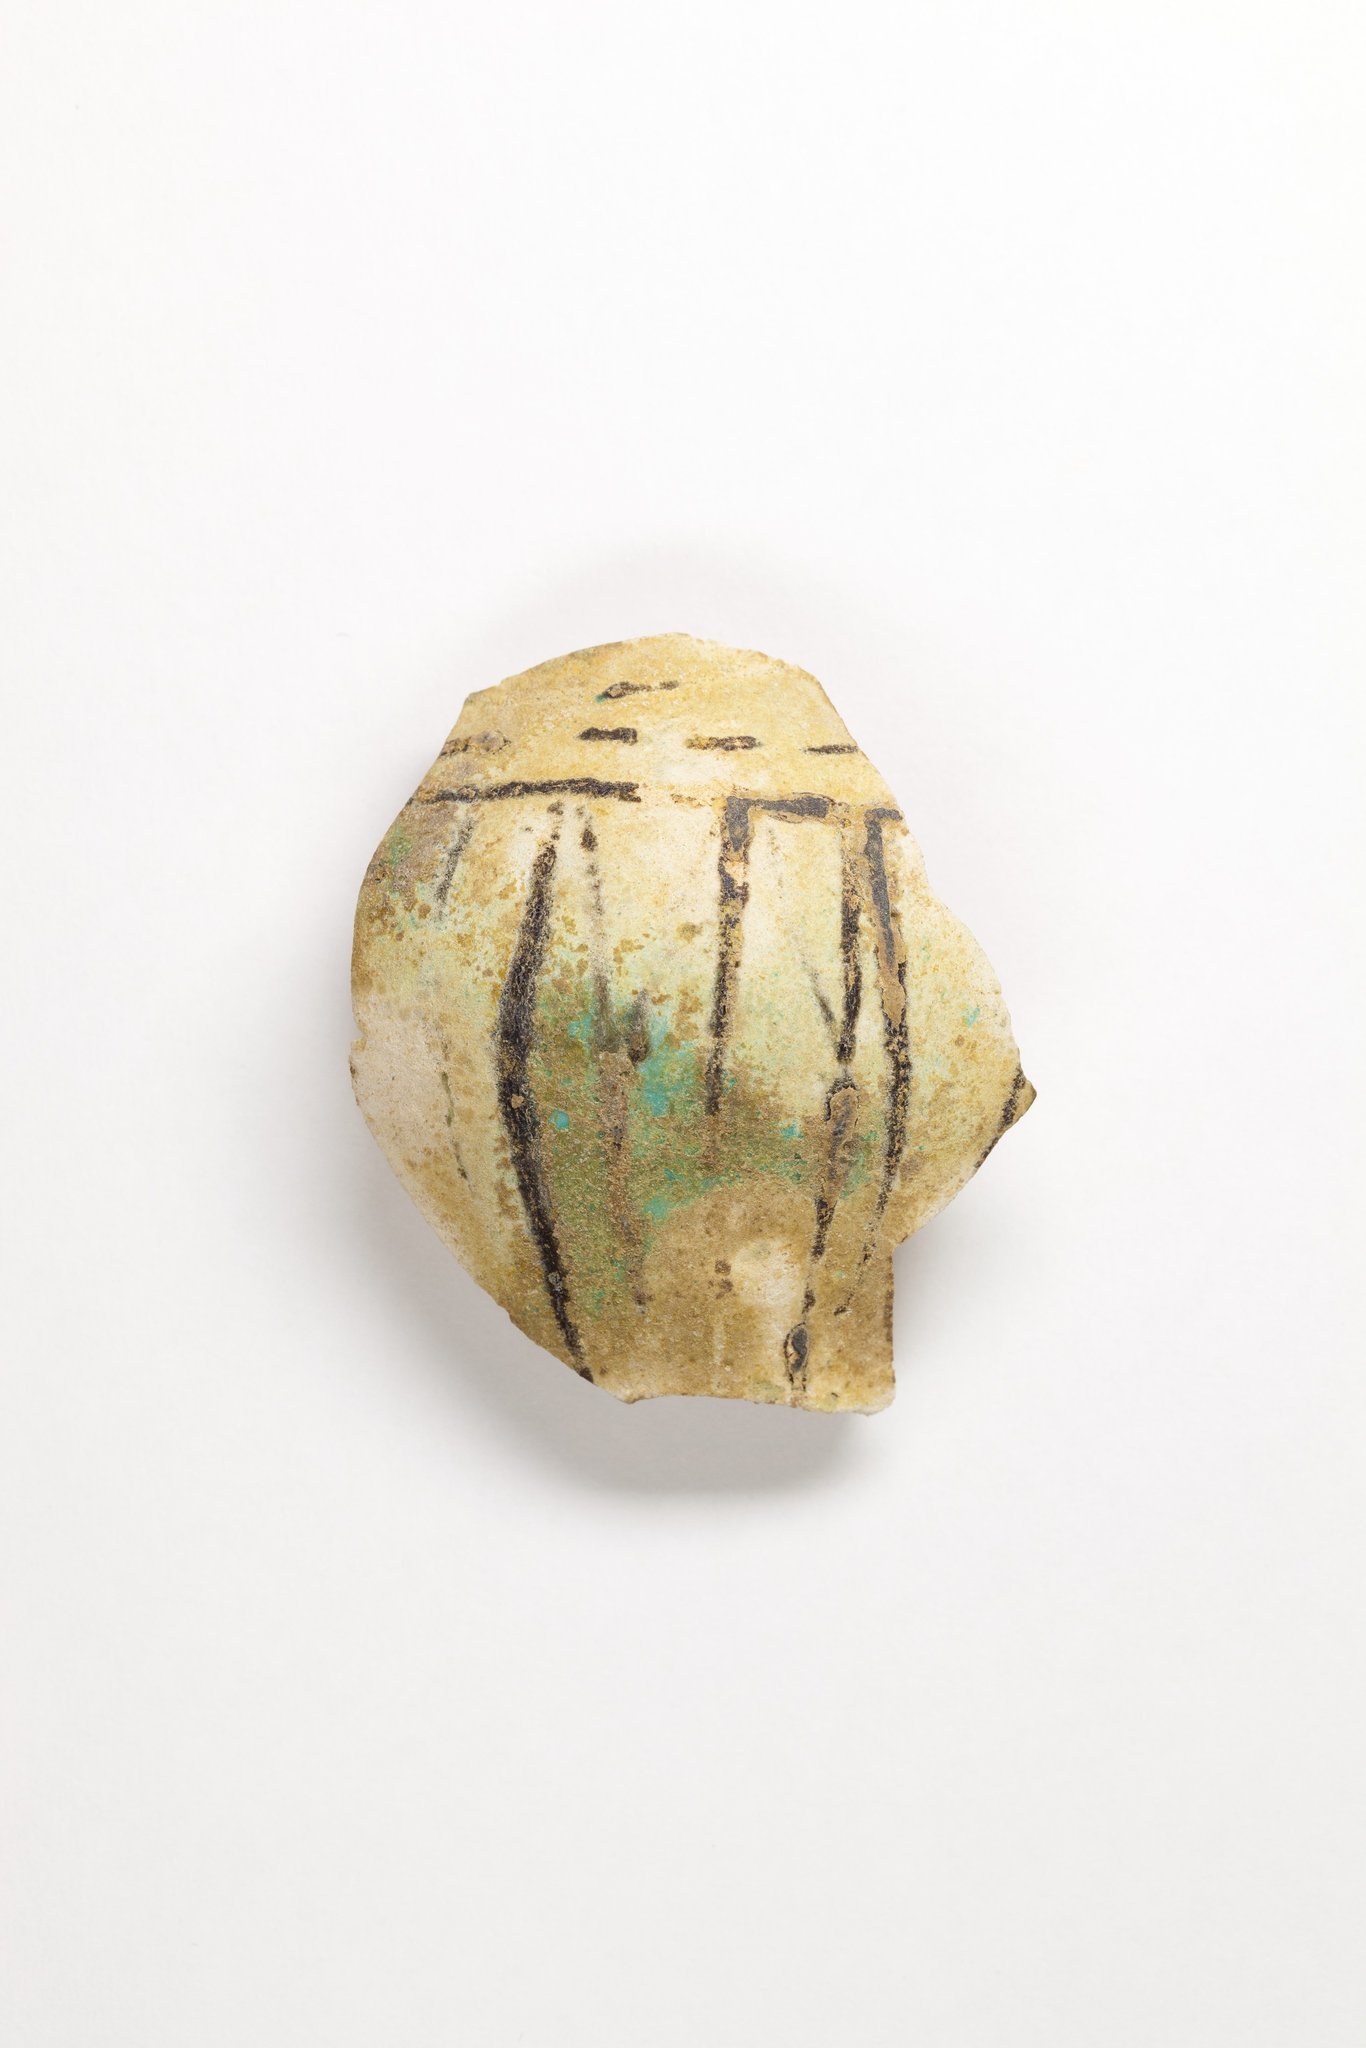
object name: vase fragment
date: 1981-1640 BCE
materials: faience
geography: egypt